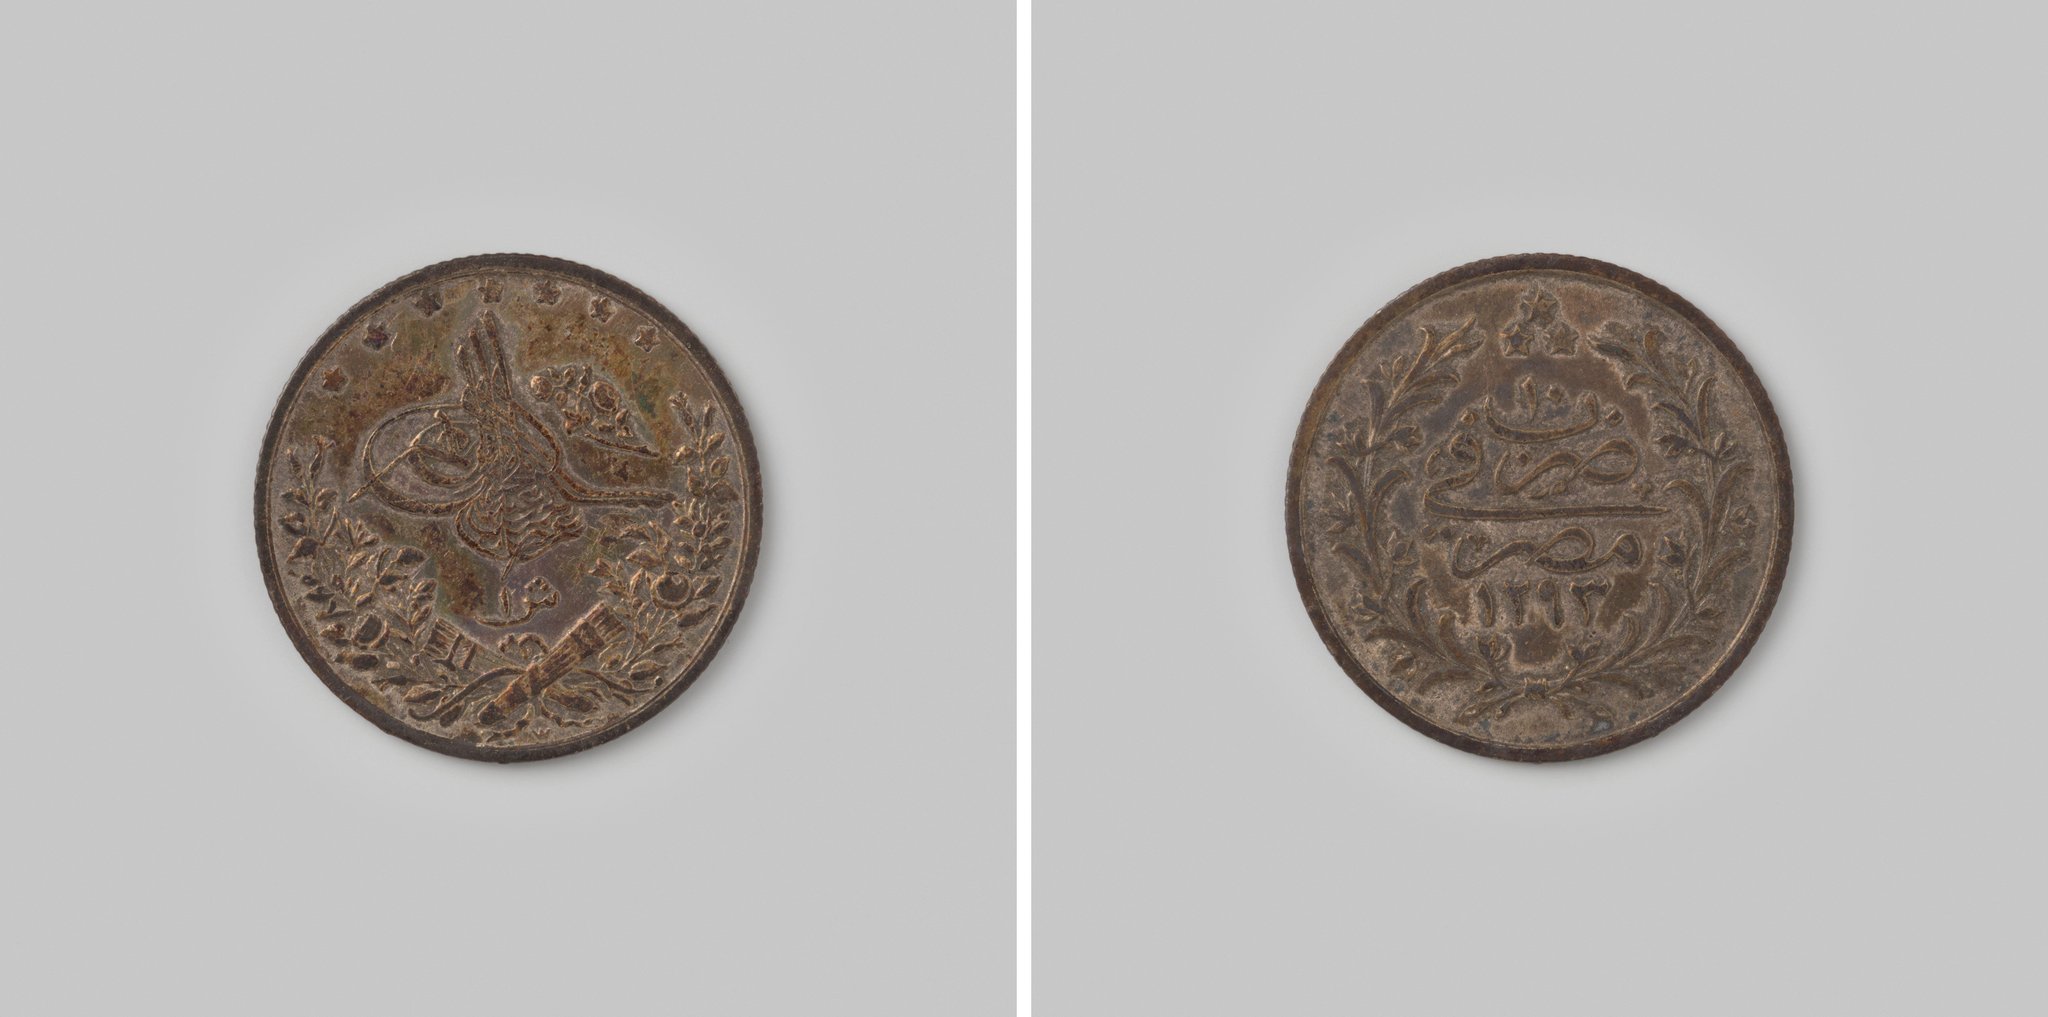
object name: coin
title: Qirsh uit Egypte van de Ottomaanse sultan Abdul Hamid II, regeringsjaar 10 [=1884]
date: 1884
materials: silver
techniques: striking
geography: cairo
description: Zilveren munt. Voorzijde: tussen twee met srtik samengebonden houders, waaruit takken, waarboven zeven sterren, tughra met rechts daarvan takje met bladeren. Onder de tughra in twee regels waarde-aanduiding:1 qirsh. Onder strik letter: W [= graveur Weigand]. Keerzijde: binnen twee samengebonden takken, waarboven drie sterren, drieregelig opschrift in Arabische letters met muntplaats-aanduiding: Misr [=Egypte]. Boven in opschrift regeringsjaar: 10. Onder muntplaats-aanduiding jaar van aantreden:1293 [=1875]. Kartelrand.